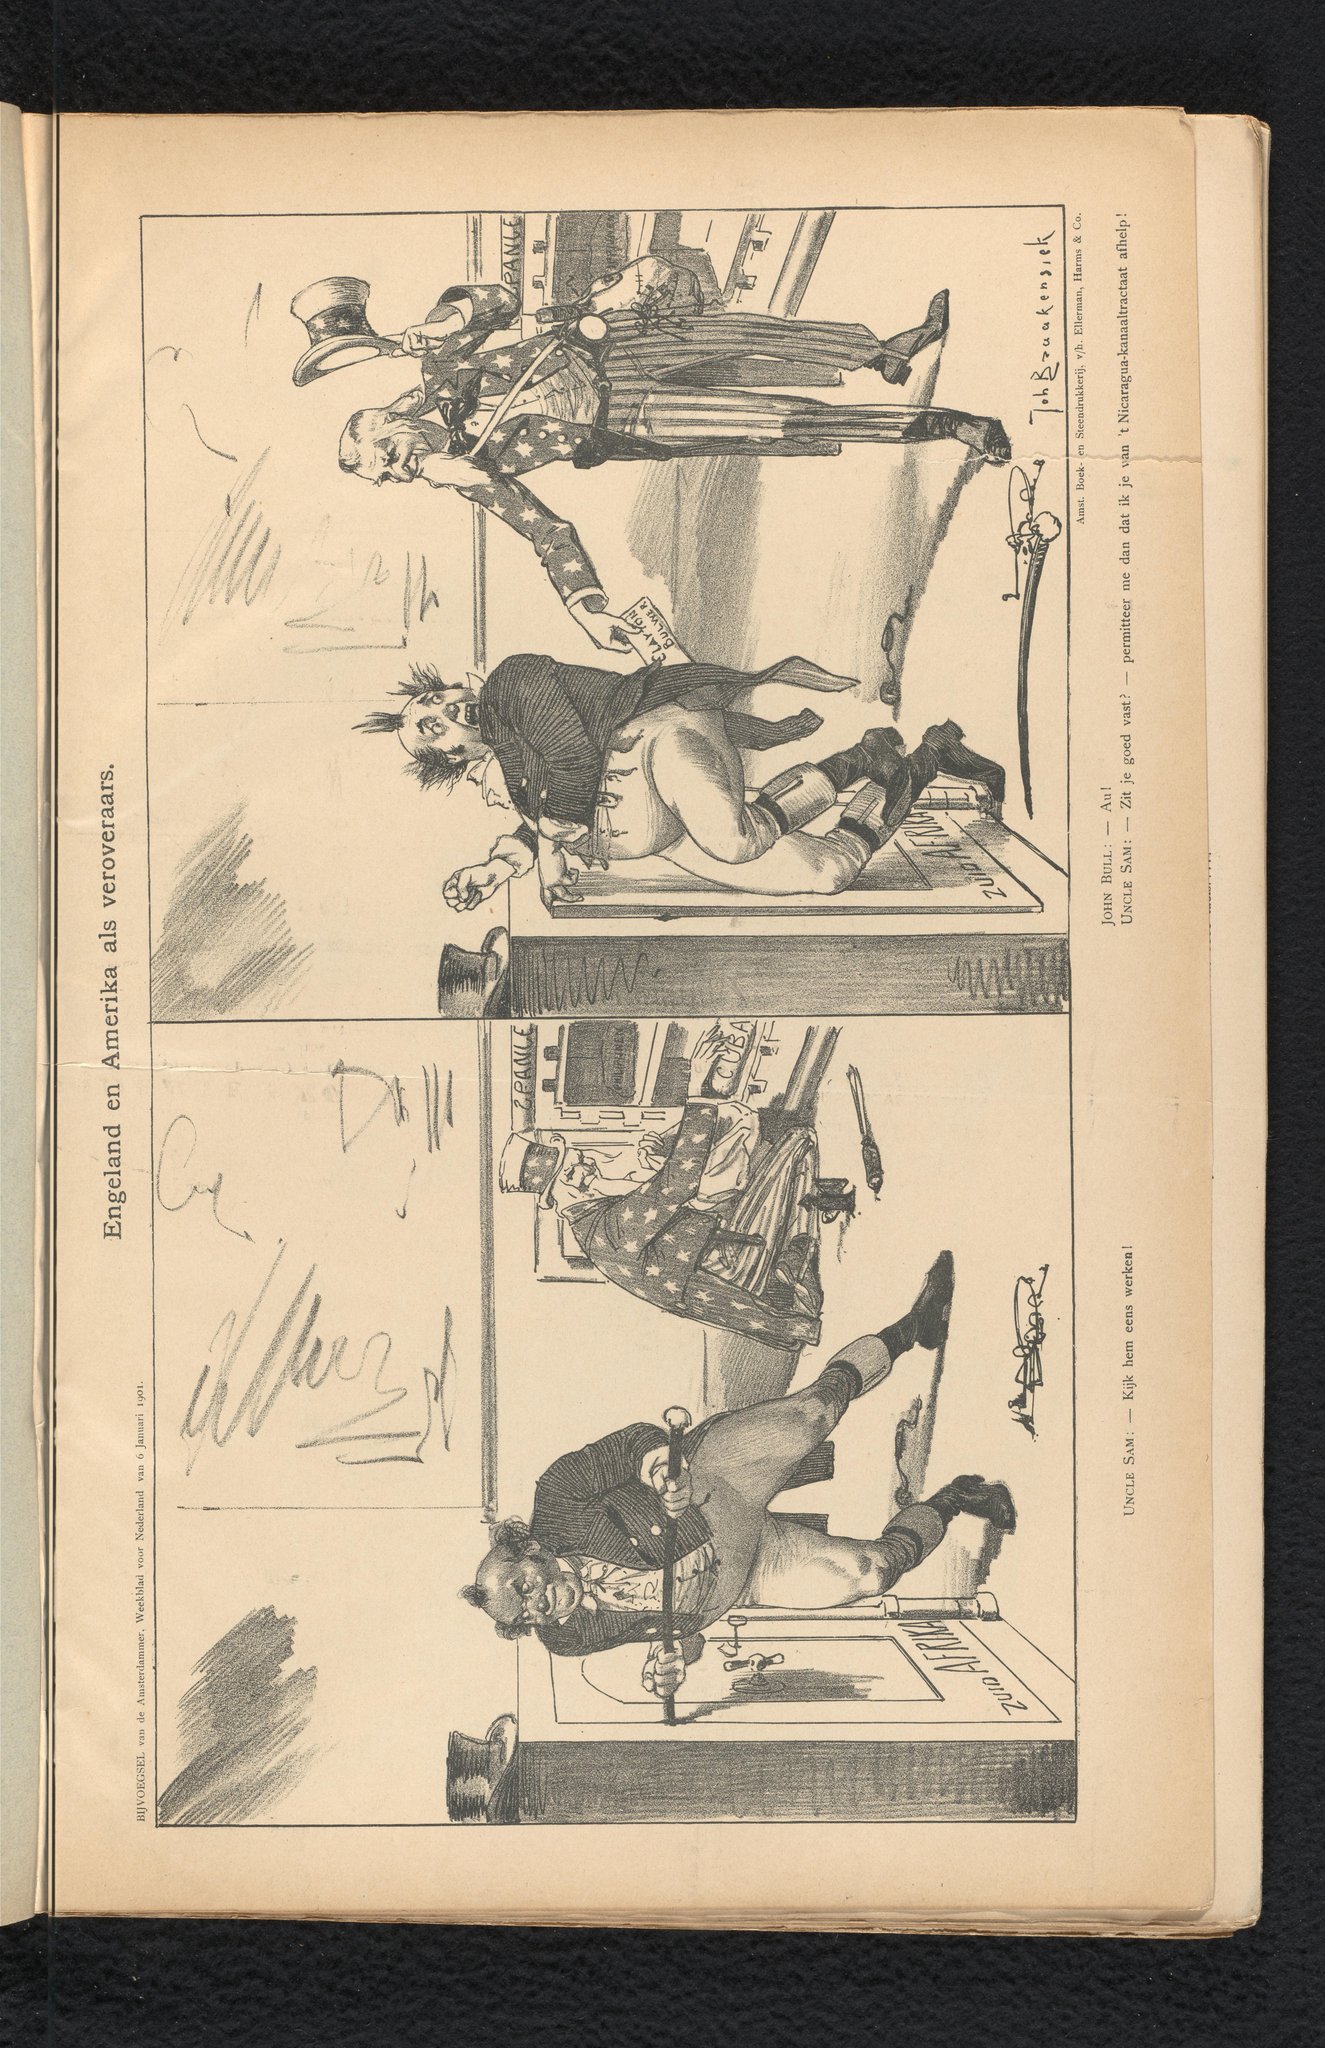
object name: cartoon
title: Engeland en Amerika als veroveraars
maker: johan braakensiek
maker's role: draughtsman, print maker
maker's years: 1858-1940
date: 1901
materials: paper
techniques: lithograph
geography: amsterdam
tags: imperialism, personifications of countries, nations, states, districts, etc., burglar, housebreaker, safe, strongbox, thief, political caricatures and satires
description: Twee voorstellingen van John Bull (Engeland) en Uncle Sam (Verenigde Staten) als inbrekers. Terwijl Engeland probeert de brandkast van Zuid-Afrika te kraken haalt de Verenigde Staten Cuba uit de kluis van Spanje en pikt terloops volgens het Clayton–Bulwer verdrag het plan voor het Nicaraguakanaal in.